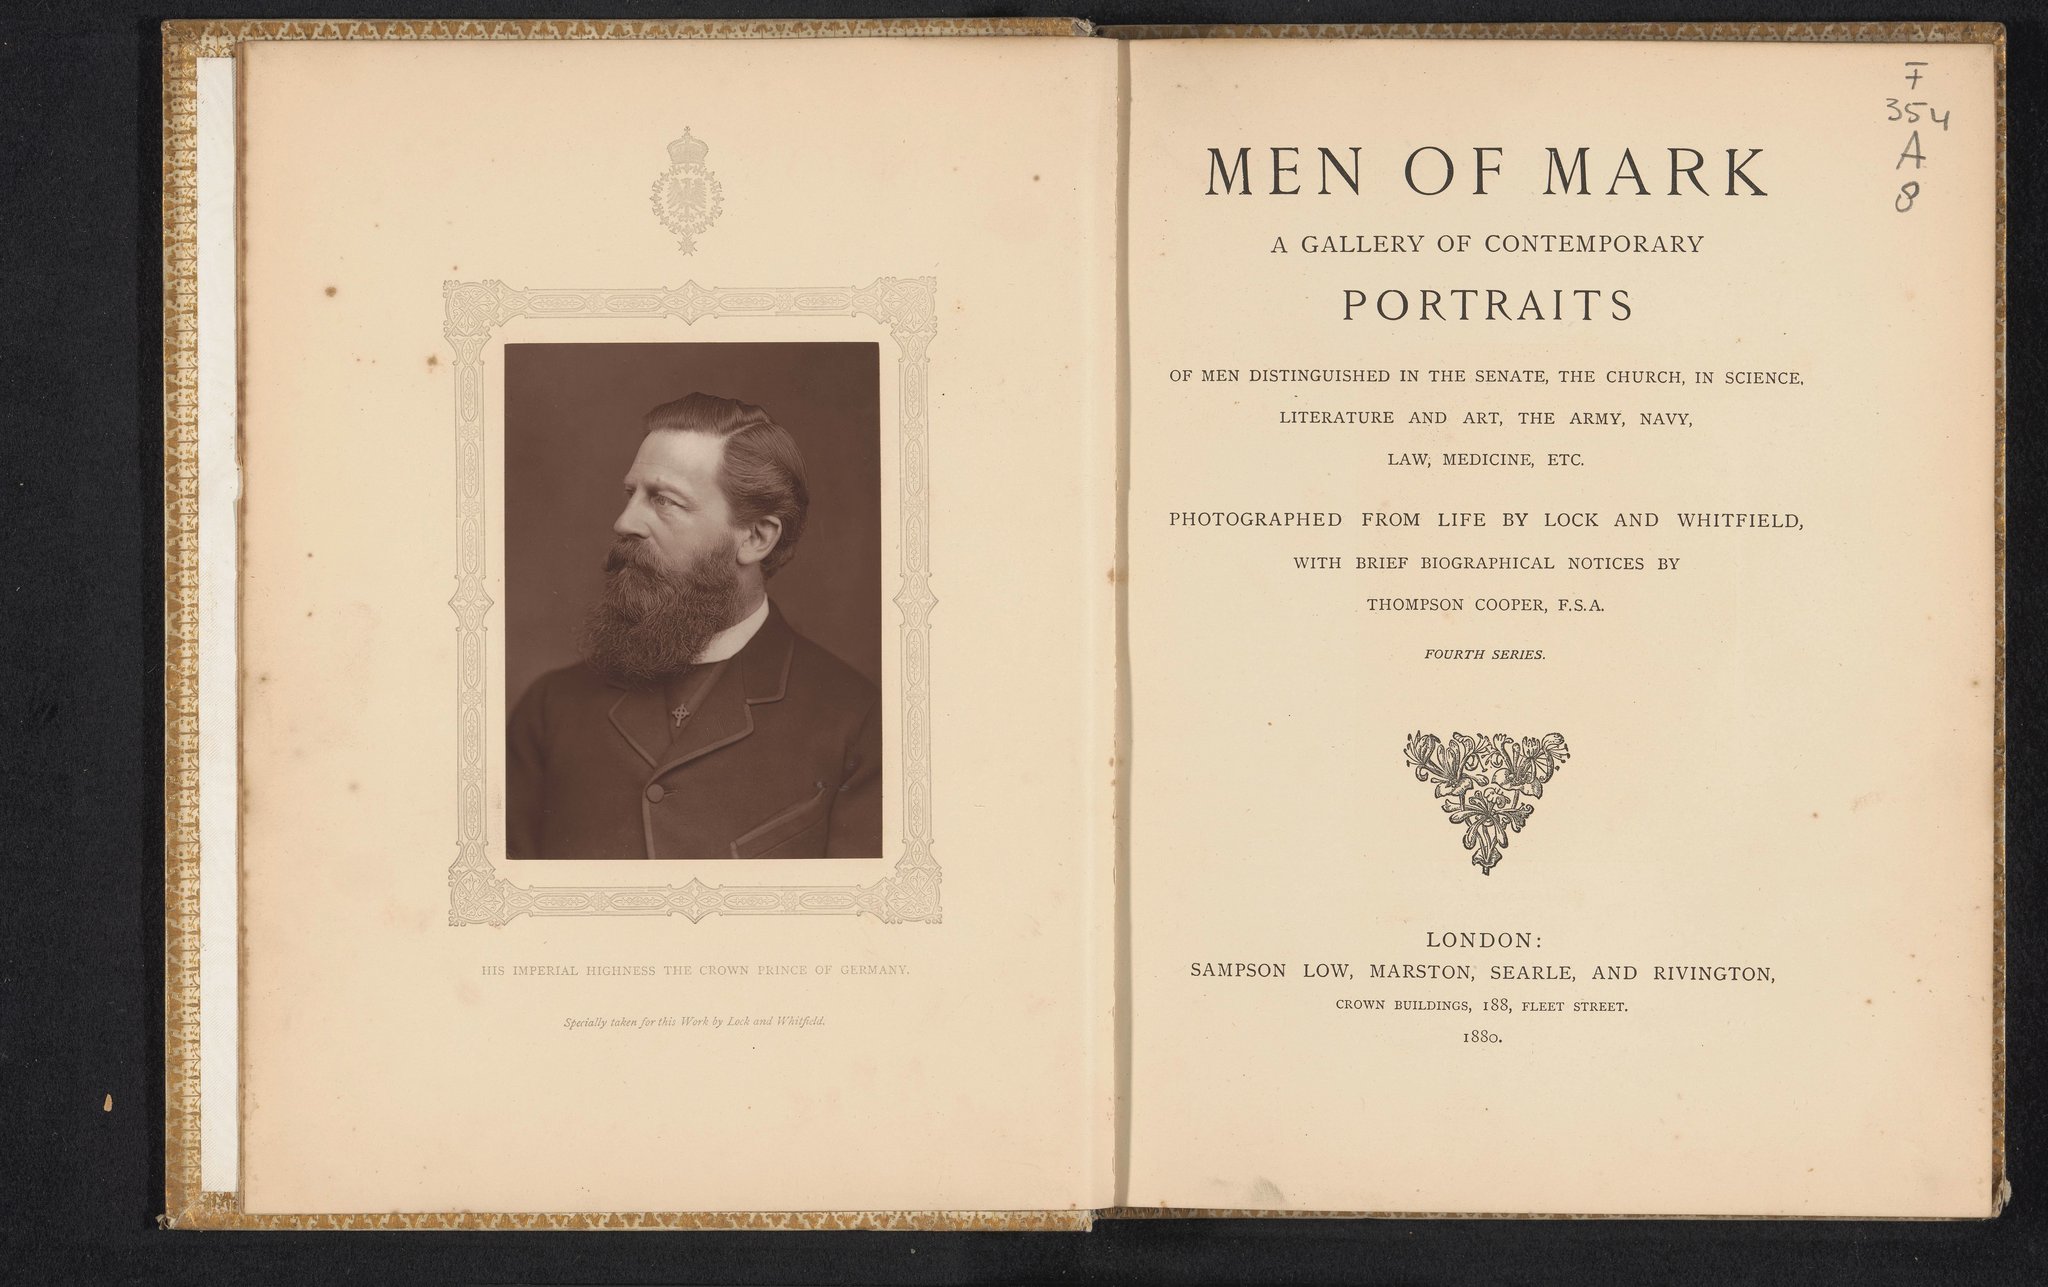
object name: book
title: Men of mark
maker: thompson cooper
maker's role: schrijver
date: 1880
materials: cardboard, linen, paper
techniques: printing, woodburytype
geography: london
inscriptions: inscription: ‘Booksellers stationers Greene's Library 16 Clare Street Dublin’